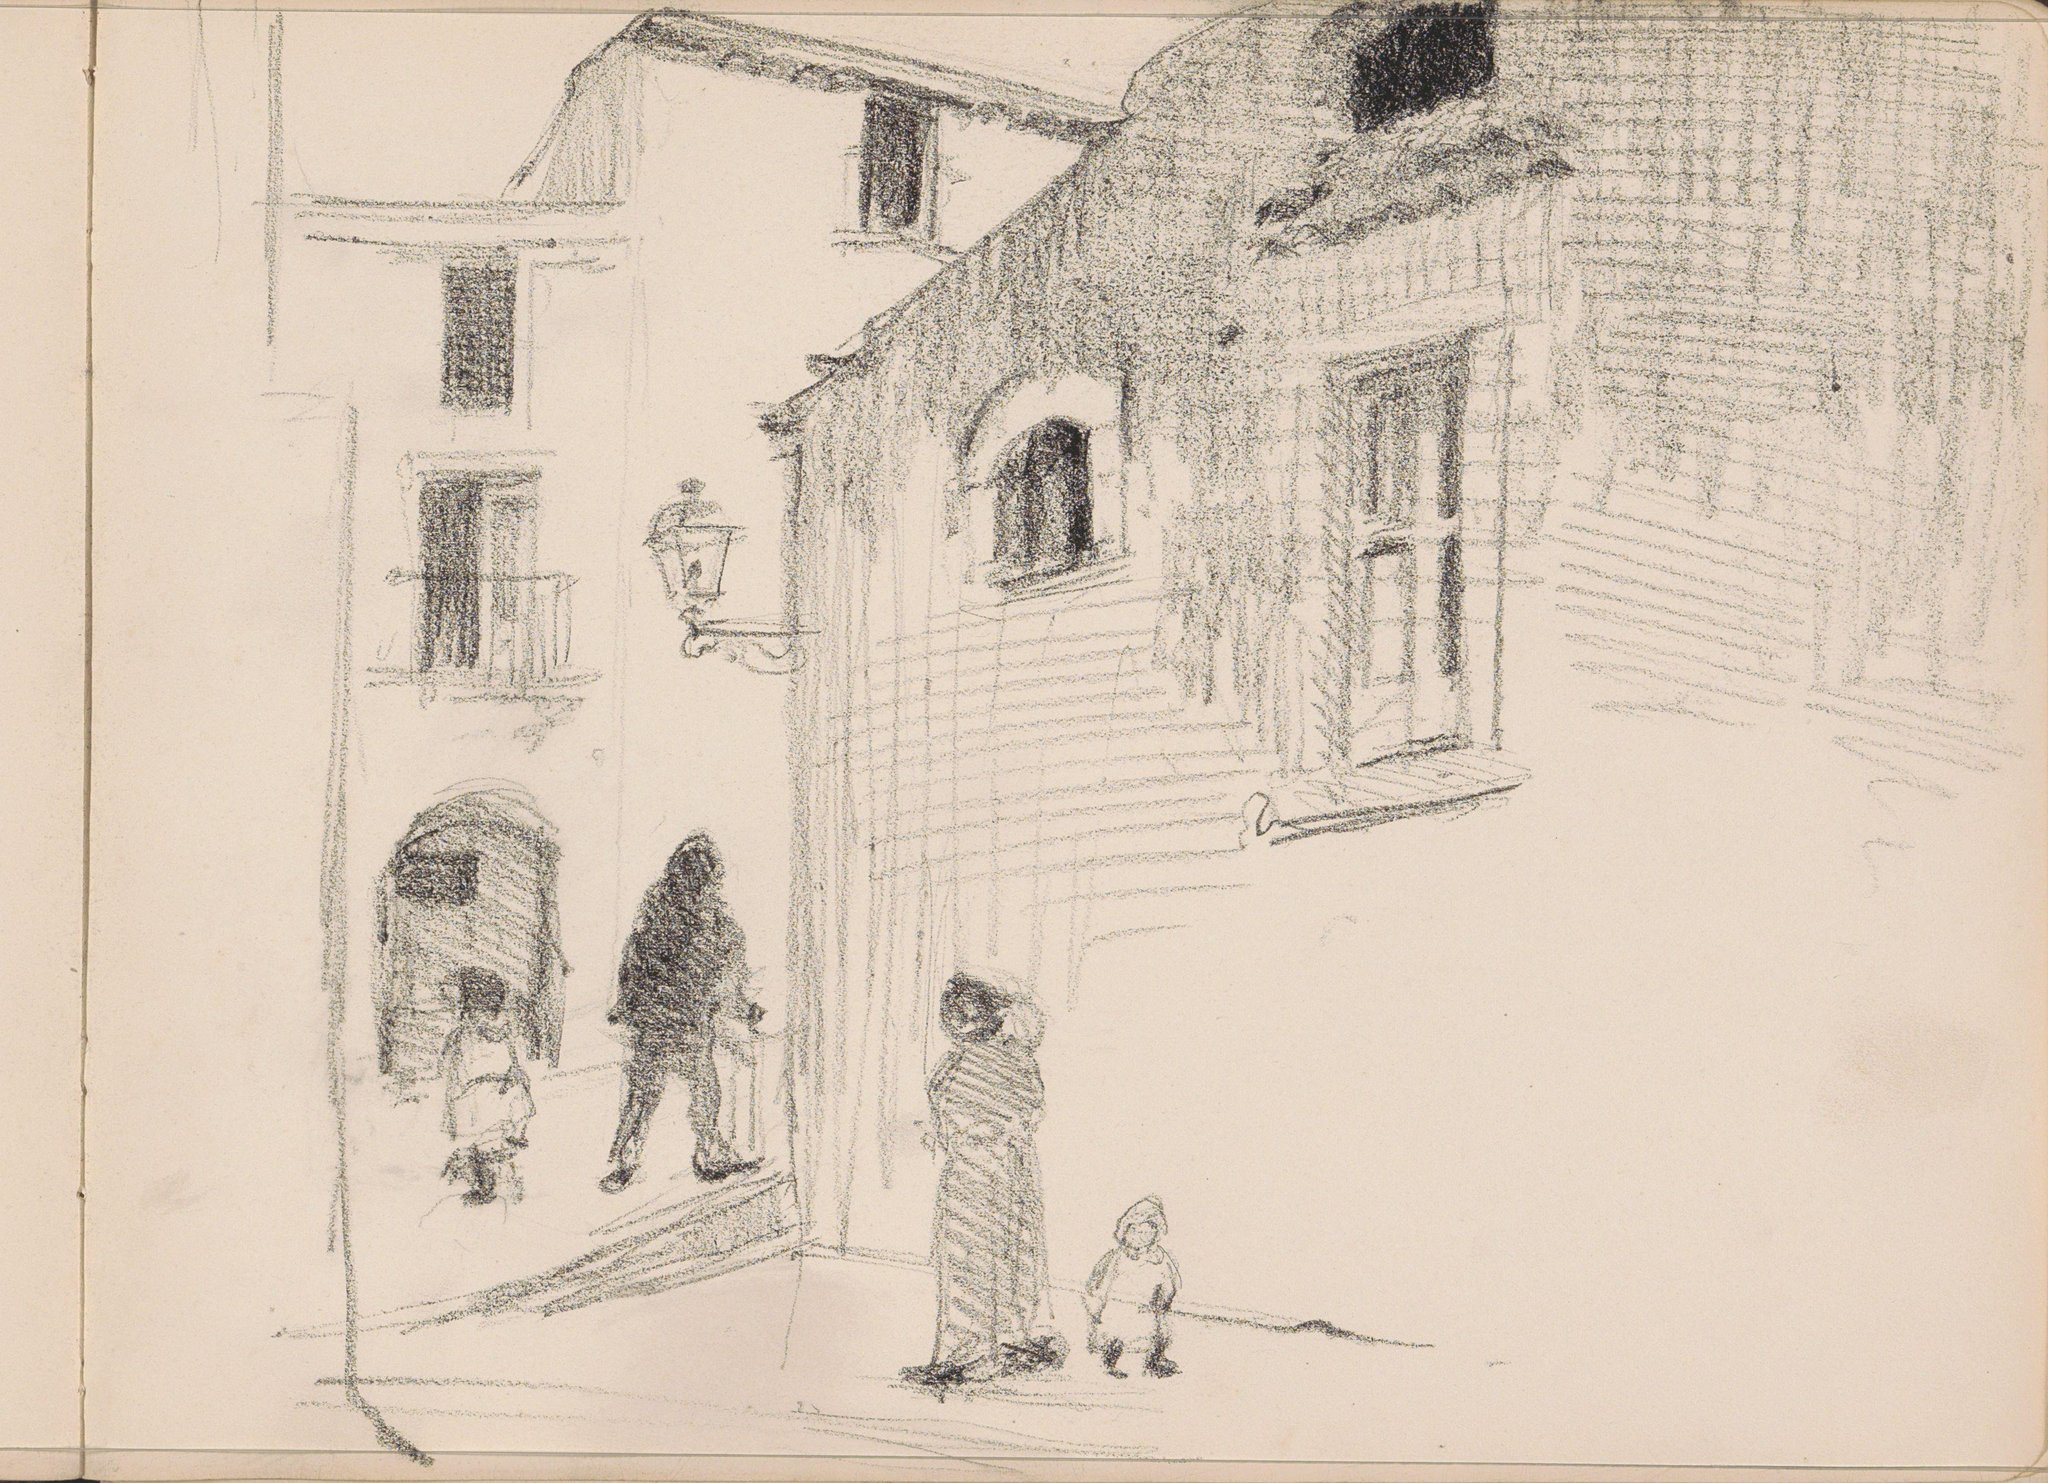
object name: sketchbook leaf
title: Straat met figuren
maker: a.a.l. de grammont-hubrecht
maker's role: draughtsman, painter, print maker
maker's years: 1855-1913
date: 1865-1913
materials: chalk, paper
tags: street (+ city(-scape) with figures, staffage)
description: Blad 26 recto uit een schetsboek met 39 bladen.